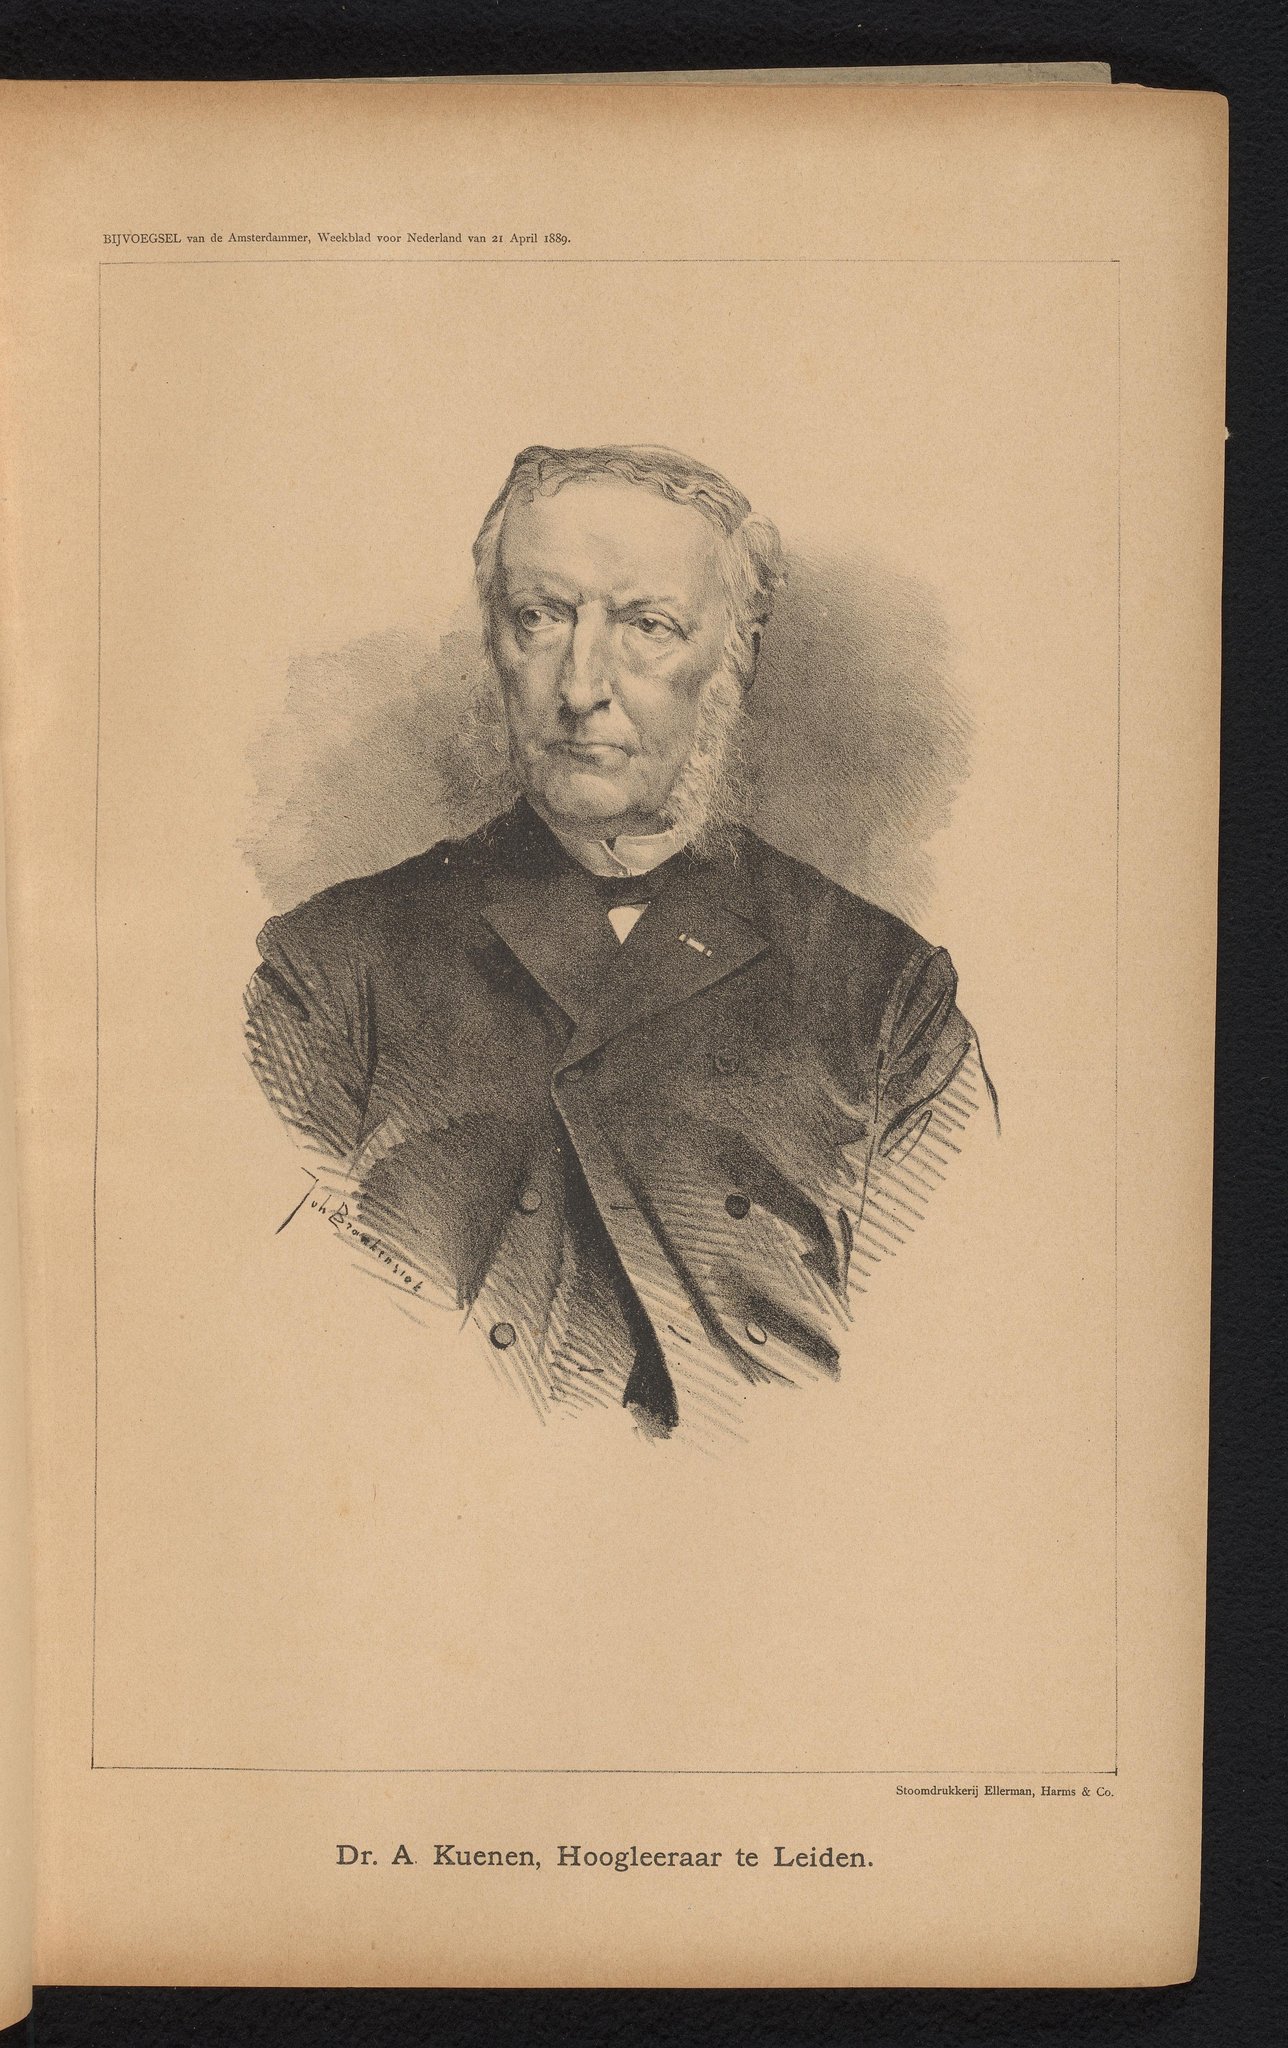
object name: print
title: Dr. A. Kuenen, Hoogleeraar te Leiden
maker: johan braakensiek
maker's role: draughtsman, print maker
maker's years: 1858-1940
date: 1889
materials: paper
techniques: lithograph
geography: amsterdam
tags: haarlem, leiden, theologian, historical persons, professor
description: Gepubliceerd als bijvoegsel bij 'De Amsterdammer', 21 april 1889.